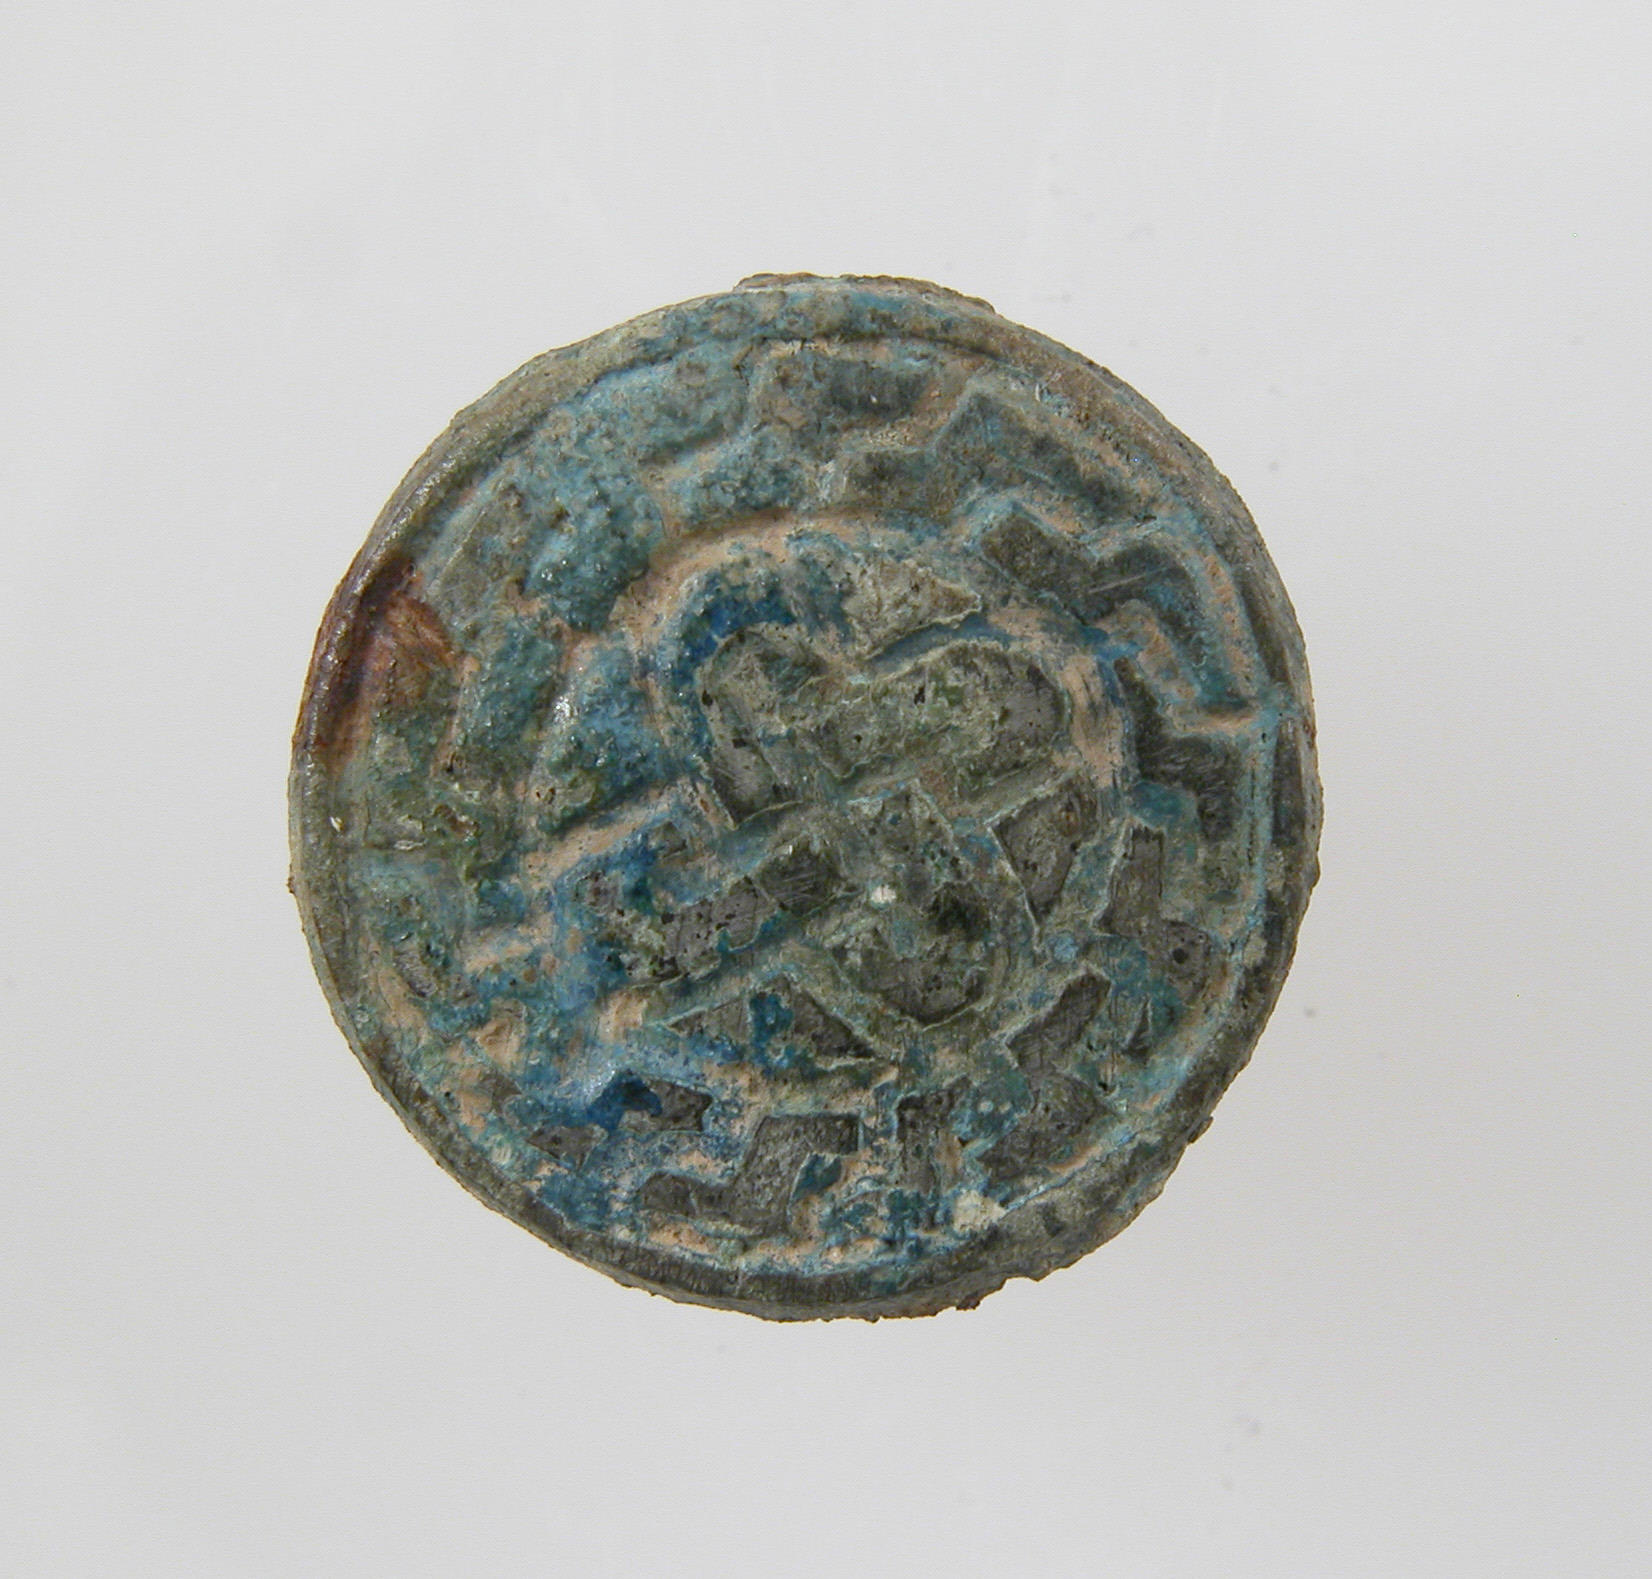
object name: stud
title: Small Circular Stud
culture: frankish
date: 601-650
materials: copper alloy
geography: germany